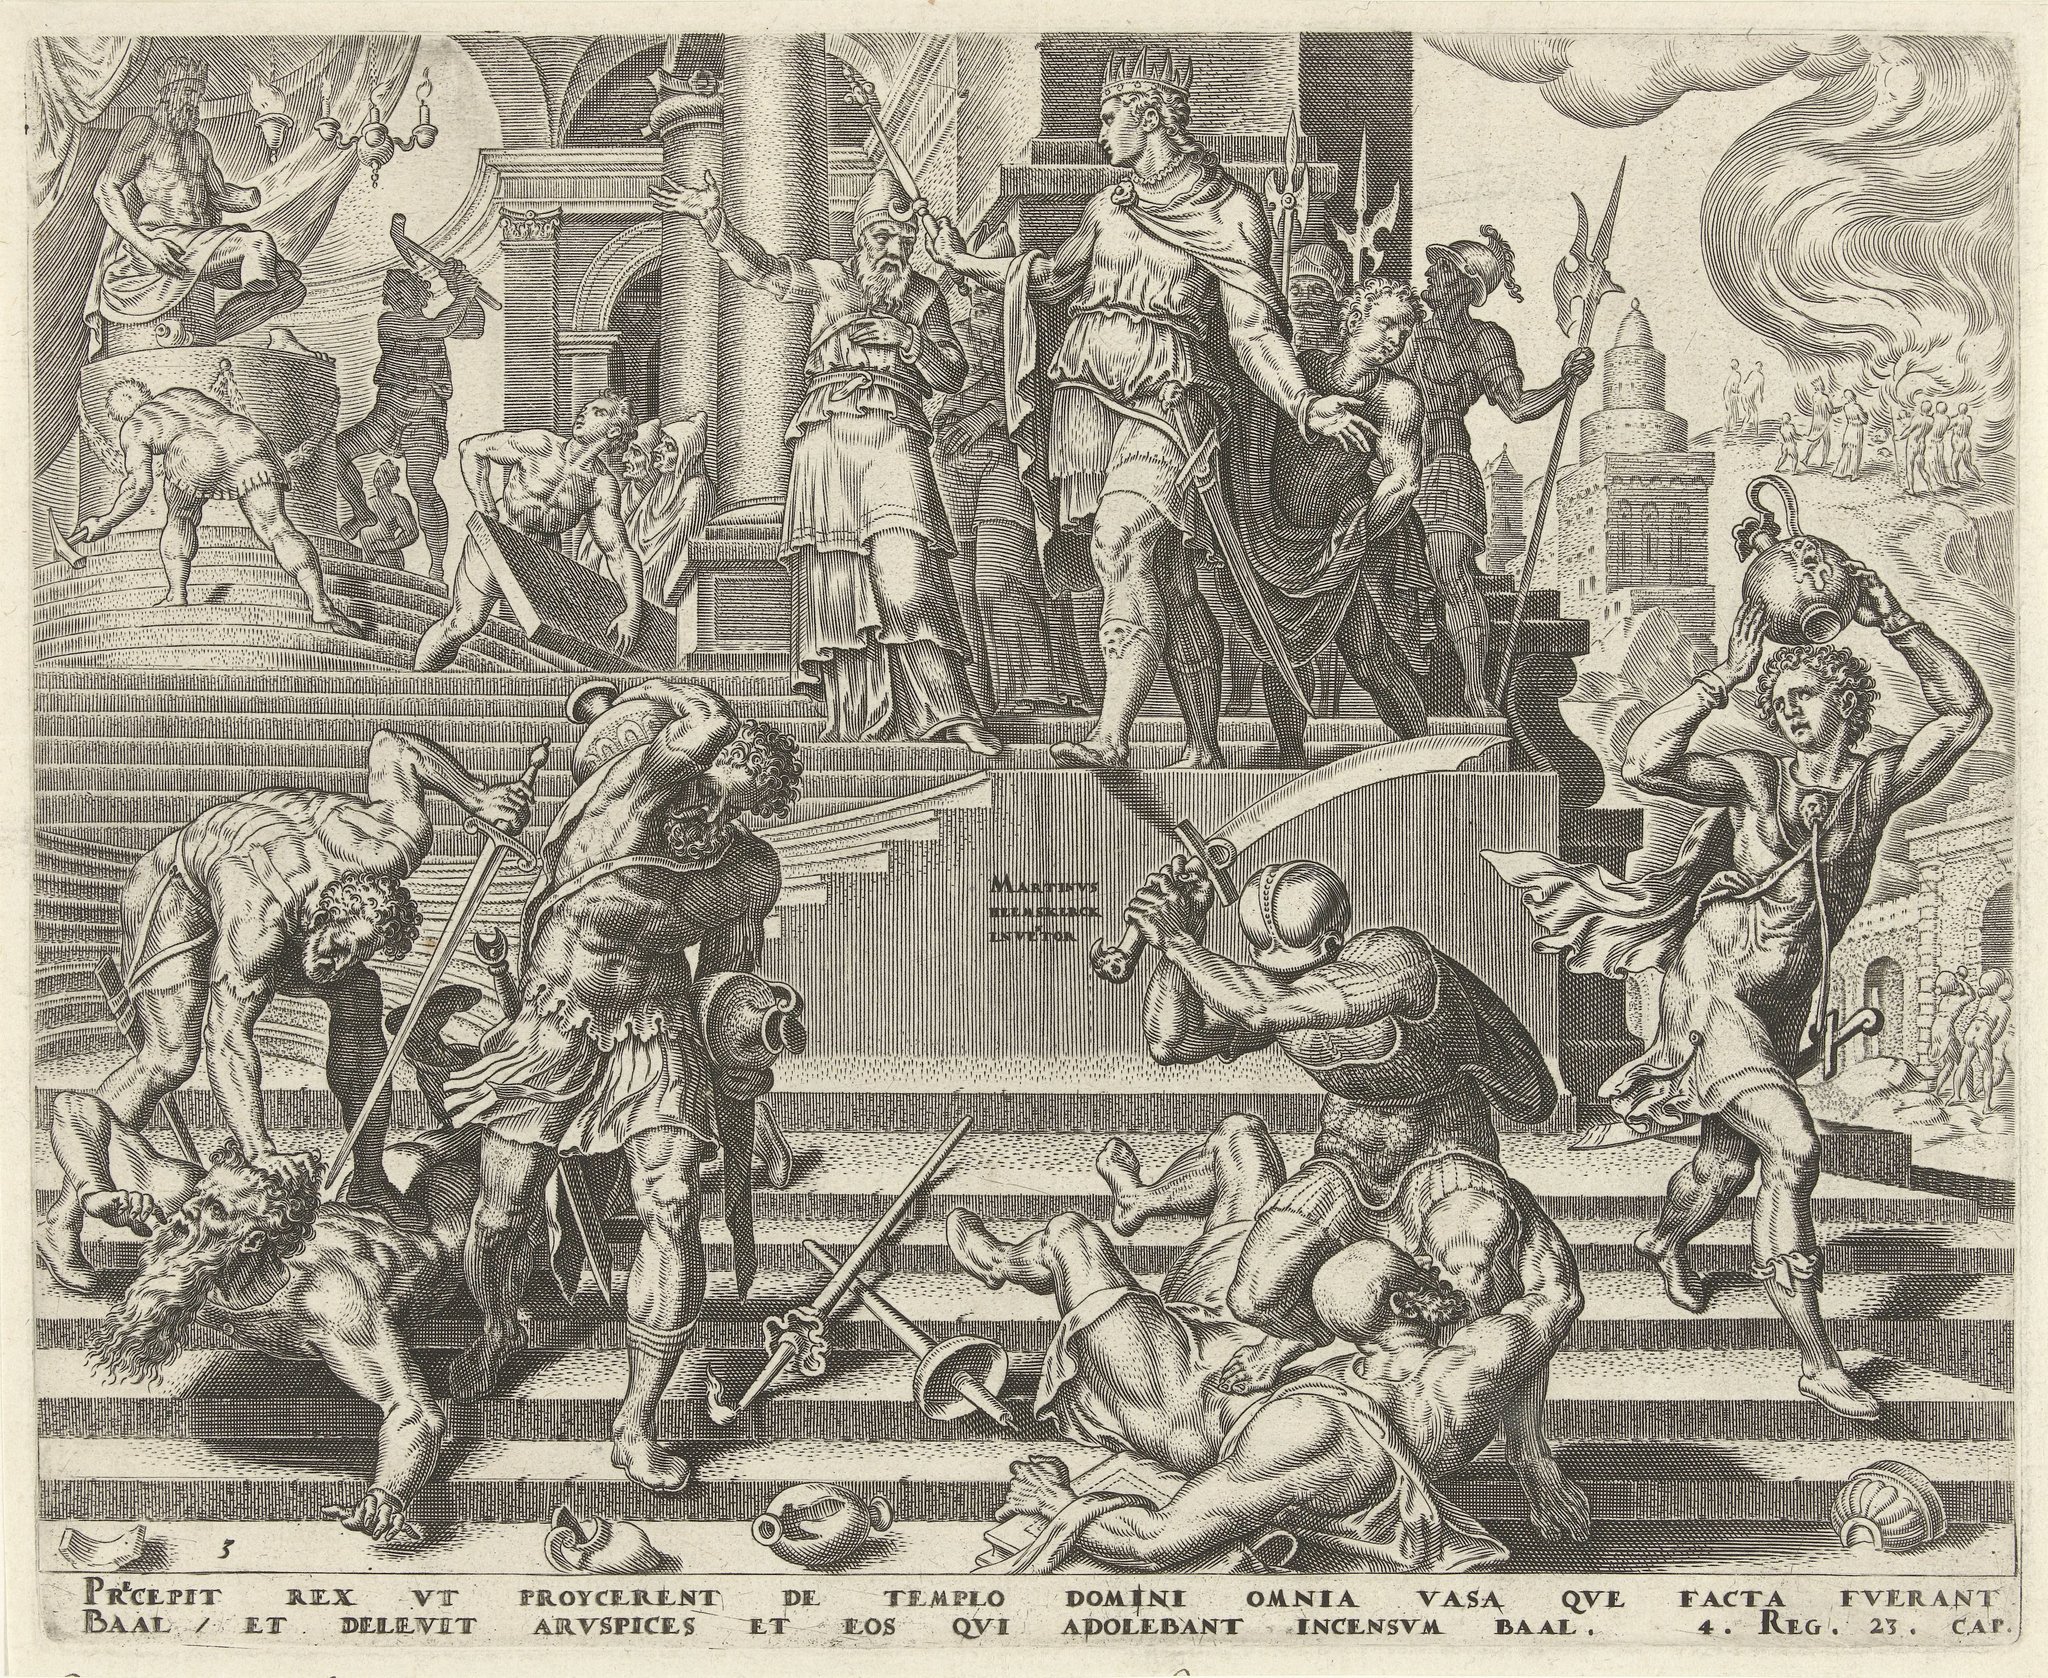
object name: print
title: Geschiedenis van koning Josia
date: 1569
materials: paper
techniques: engraving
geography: haarlem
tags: josiah does away with pagan worship, all the idols are brought out of the temple, burned, and their ashes pounded to dust ~ story of josiah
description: Koning Josia geeft opdracht om de tempel van Baäl te verwoesten en de Baälpriesters te vermoorden. Alle voorwerpen die ter ere van de afgod zijn gemaakt worden door Josia's soldaten buiten de stad verbrand. Rechtsachter is het vuur te zien.